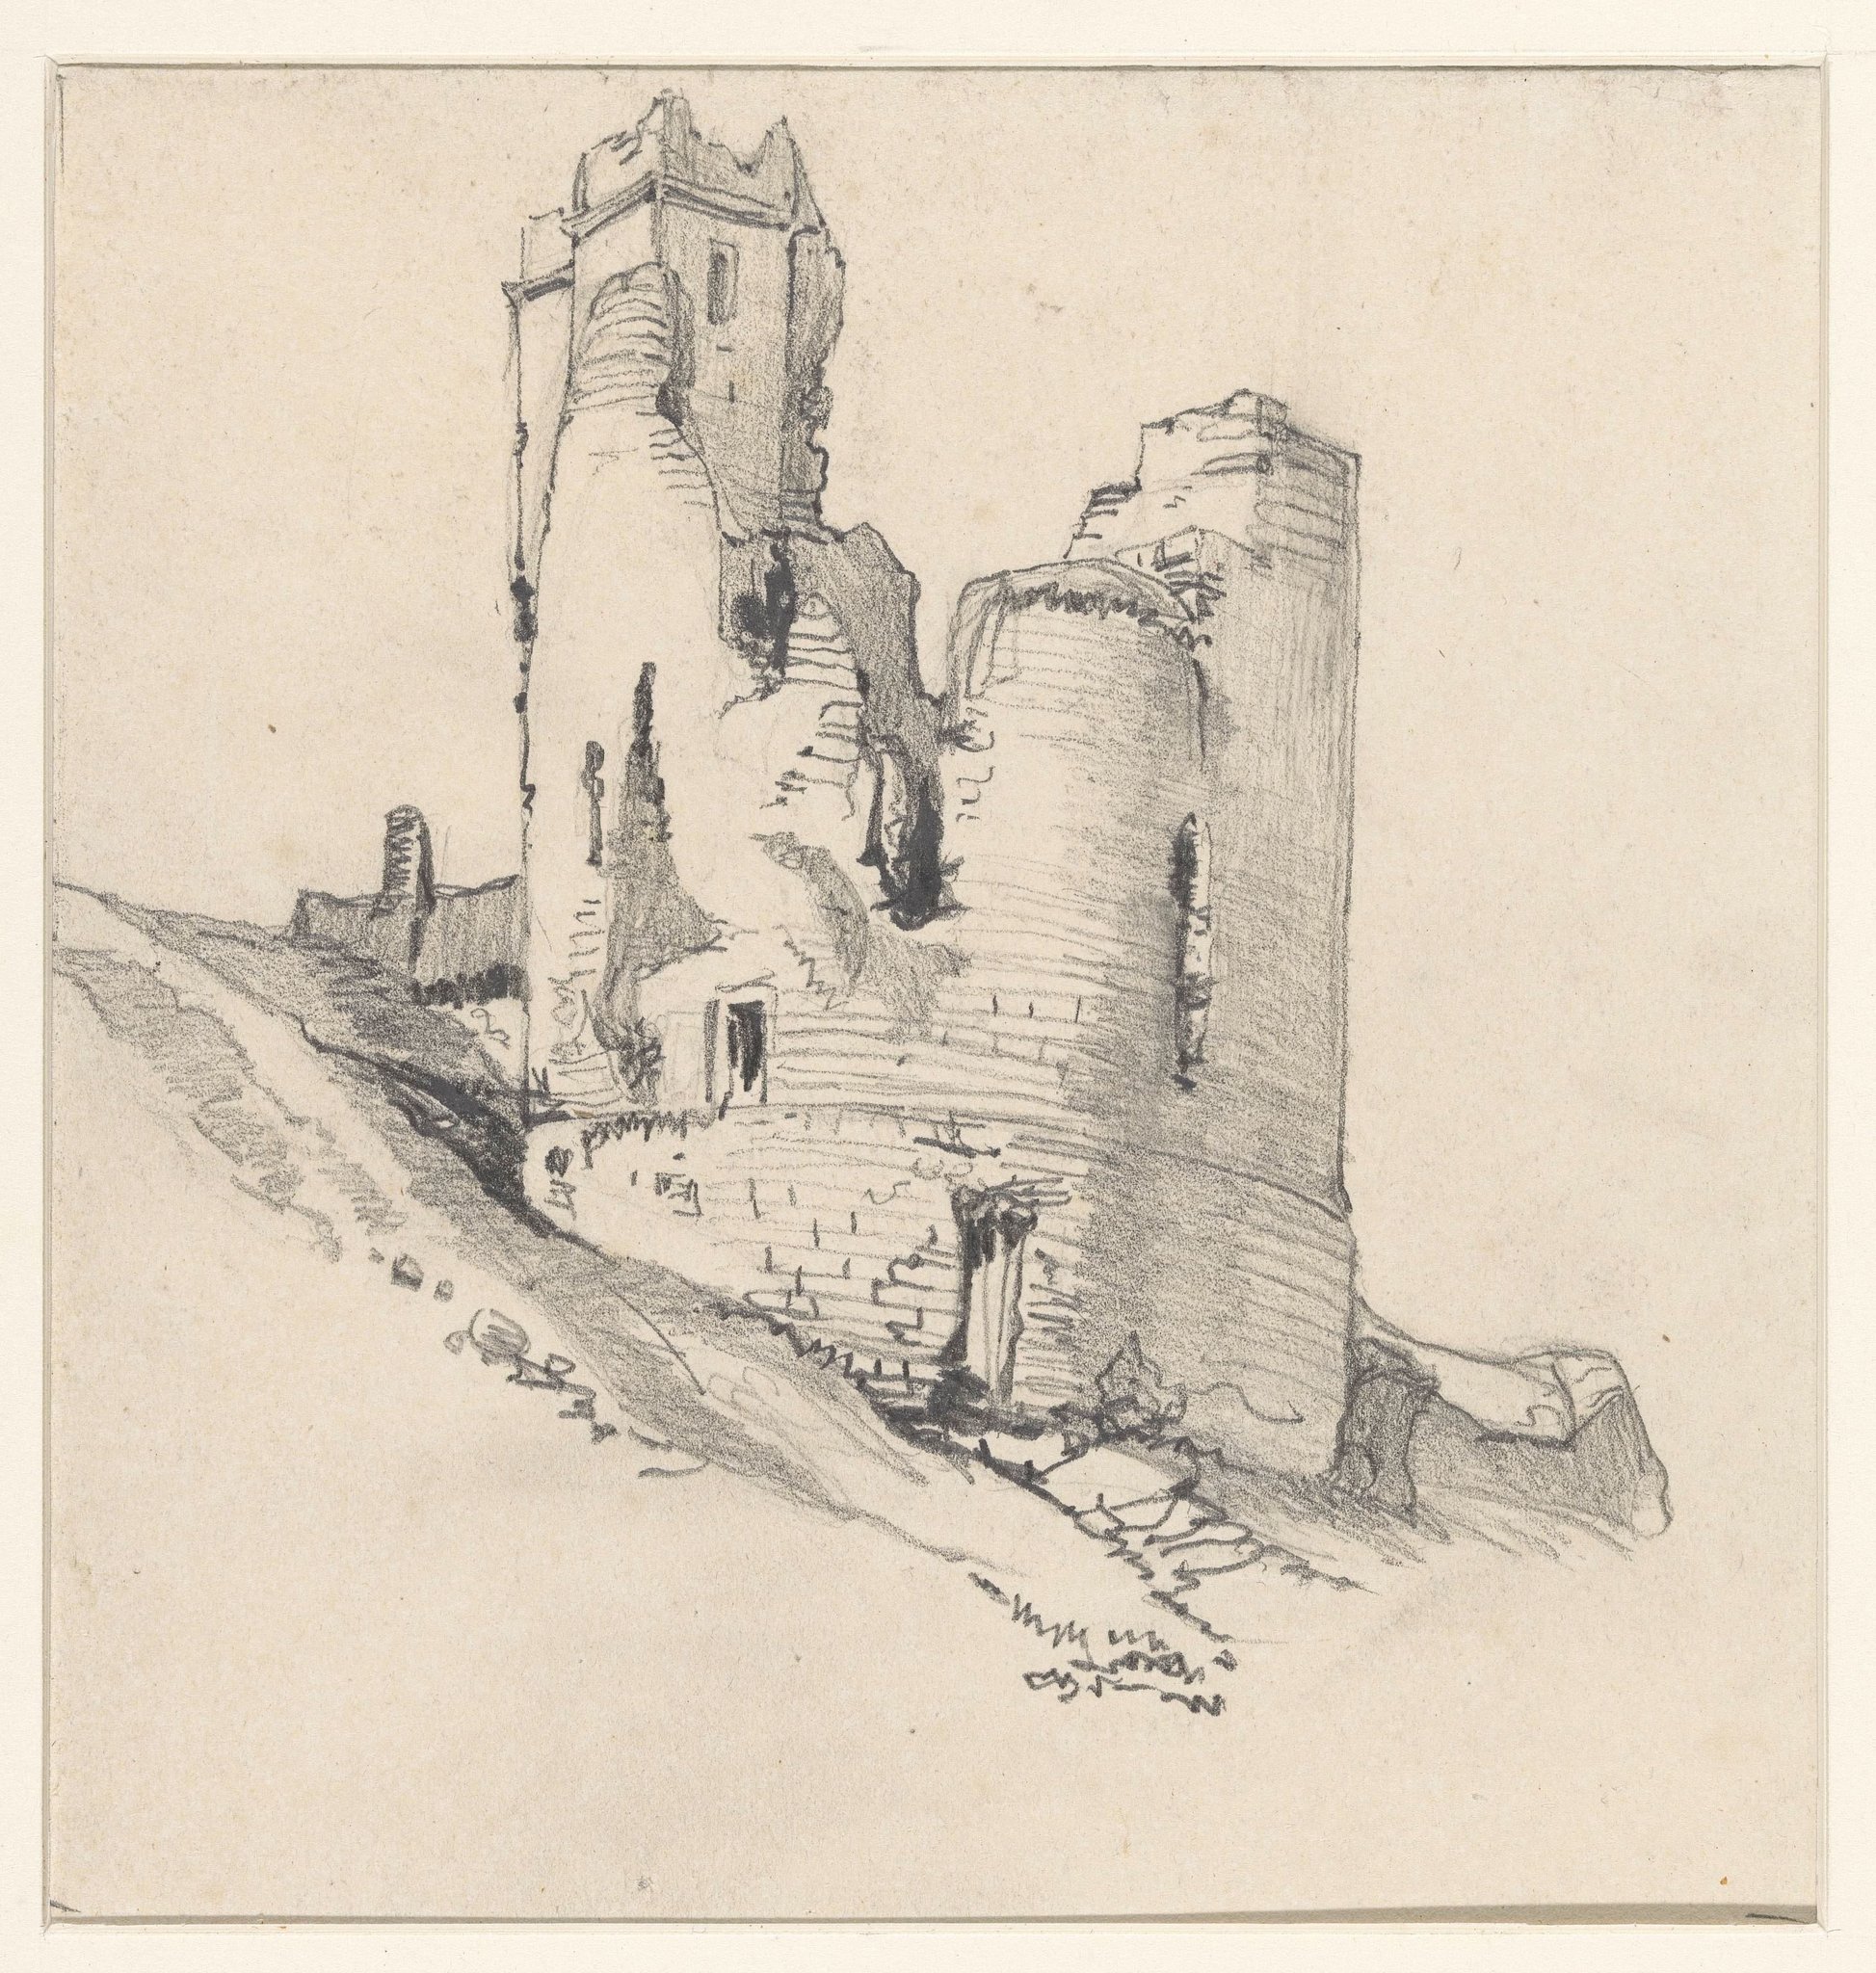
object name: drawing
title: Vervallen toren van een kasteel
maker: frederik hendrik weissenbruch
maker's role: draughtsman, print maker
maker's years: 1828-1887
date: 1838-1887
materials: paper, pencil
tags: ruin of a building ~ architecture, tower (of house or building)